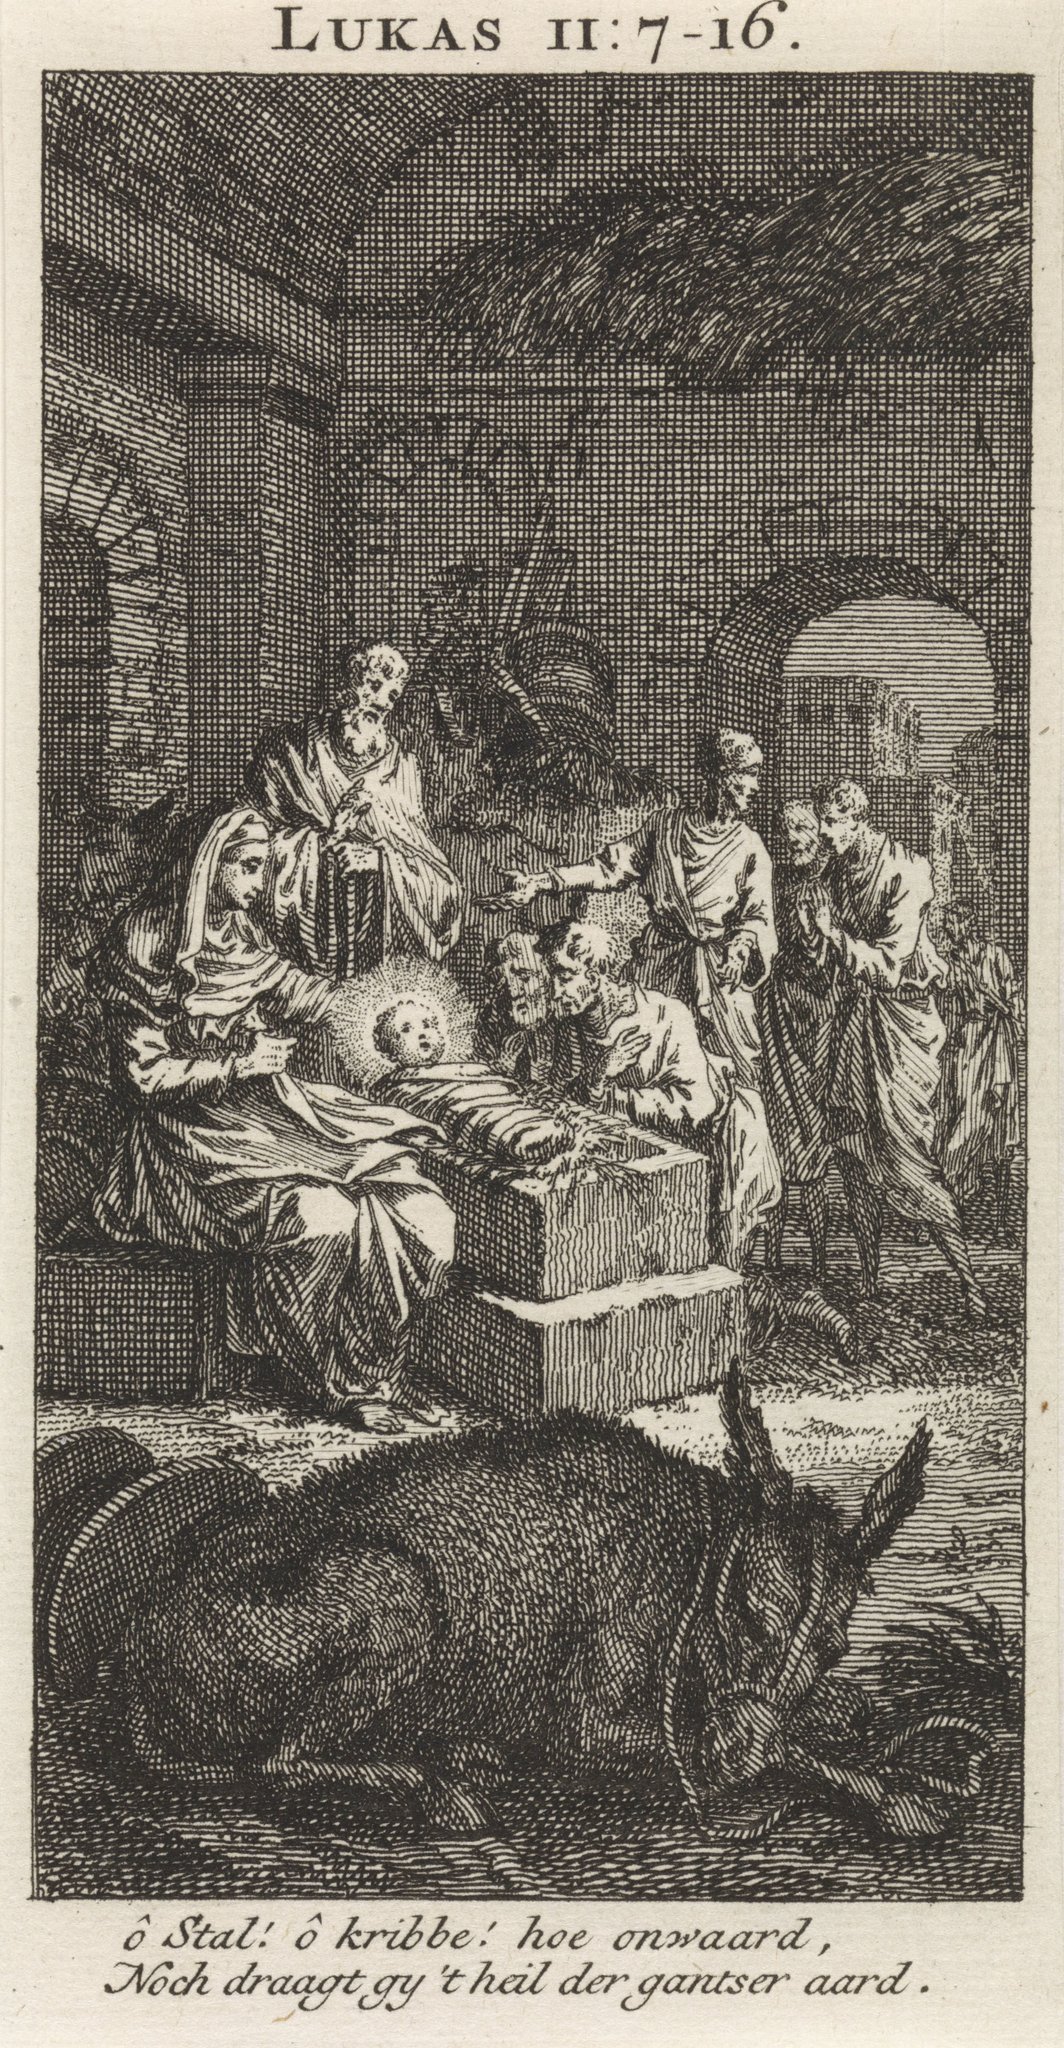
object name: print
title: Aanbidding der herders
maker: Anonymous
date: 1712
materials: paper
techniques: etching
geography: amsterdam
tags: adoration of the christ-child by the shepherds; mary and joseph present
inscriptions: collector's mark: Lugt 2228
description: Kopie naar illustratie voor: Luyken, Jan. Bybel printen. Amsterdam: Pieter Arentsz. II (wed.) en Cornelis van der Sys, 1712, p. 25.